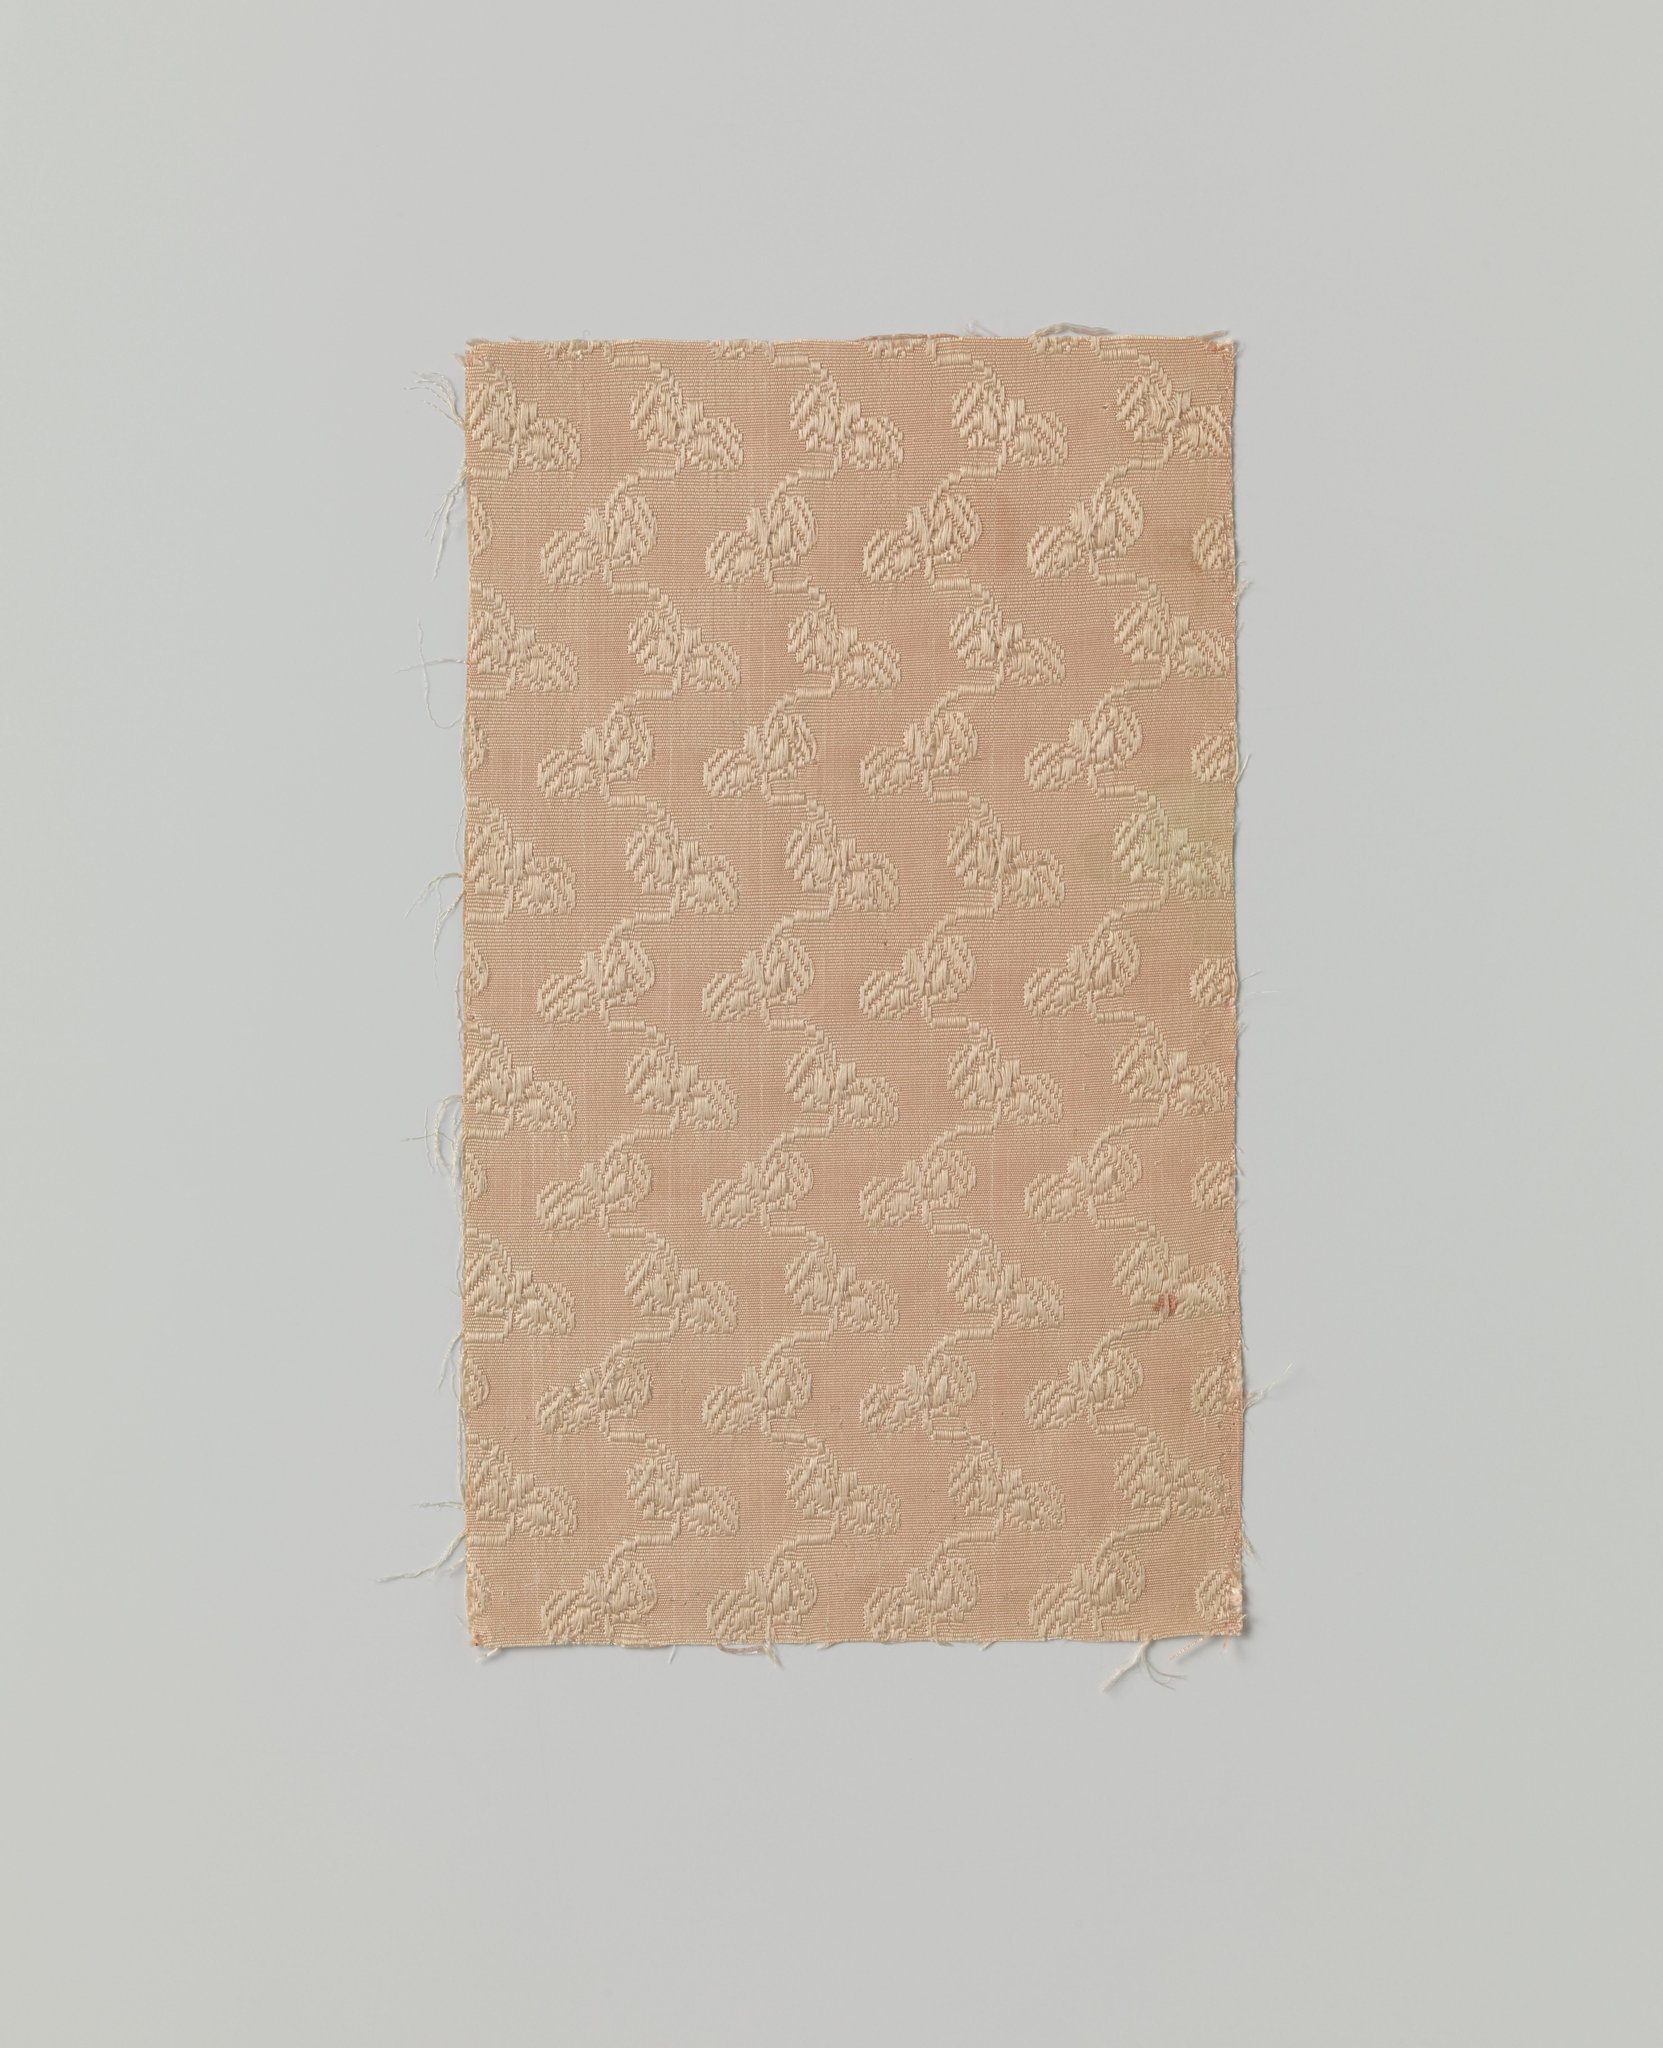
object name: fragment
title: Fragment roze zijdeweefsel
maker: Anonymous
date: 1750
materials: silk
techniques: droguet, liseré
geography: germany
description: Een fragment roze zijdeweefsel. Het patroon heeft lichtroze golvende bladslingers.